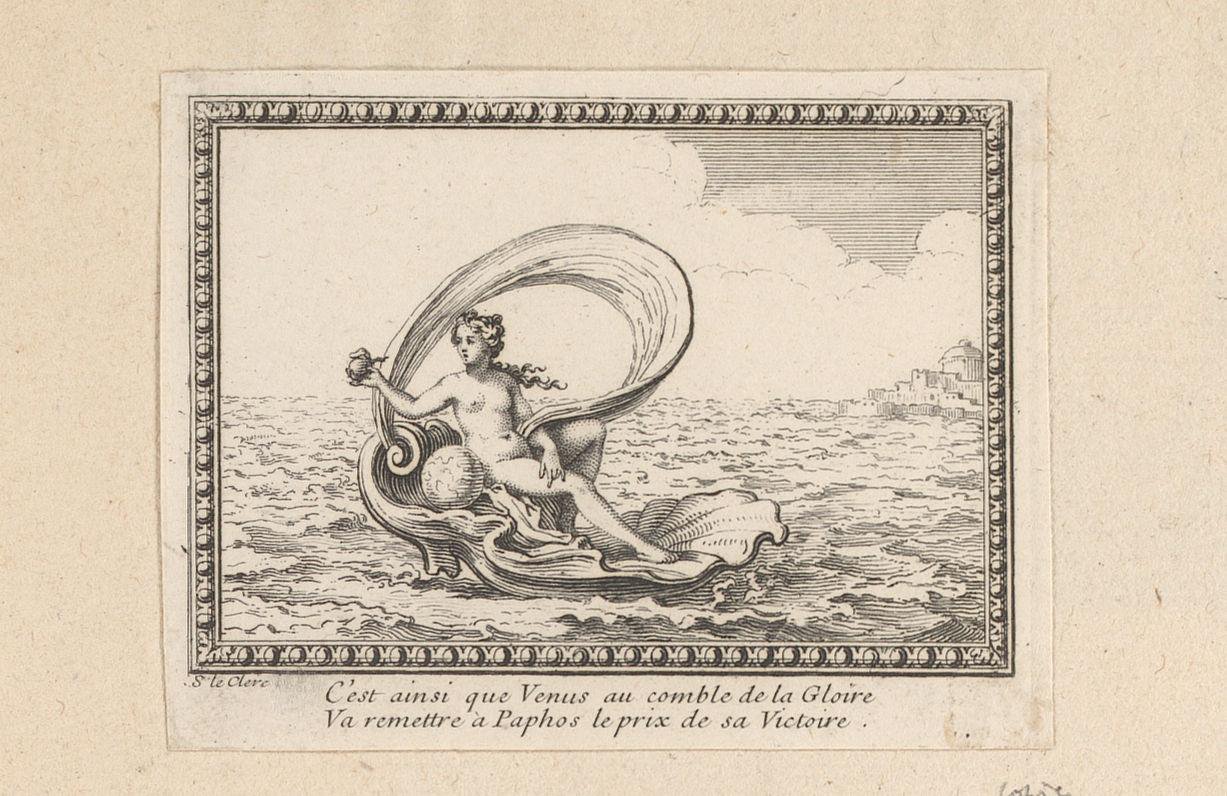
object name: album leaf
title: Venus Marina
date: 1647-1714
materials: paper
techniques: etching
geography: france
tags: venus, standing on a shell, sails with her veil over the water (alternatively she is riding on a dolphin): venus marina